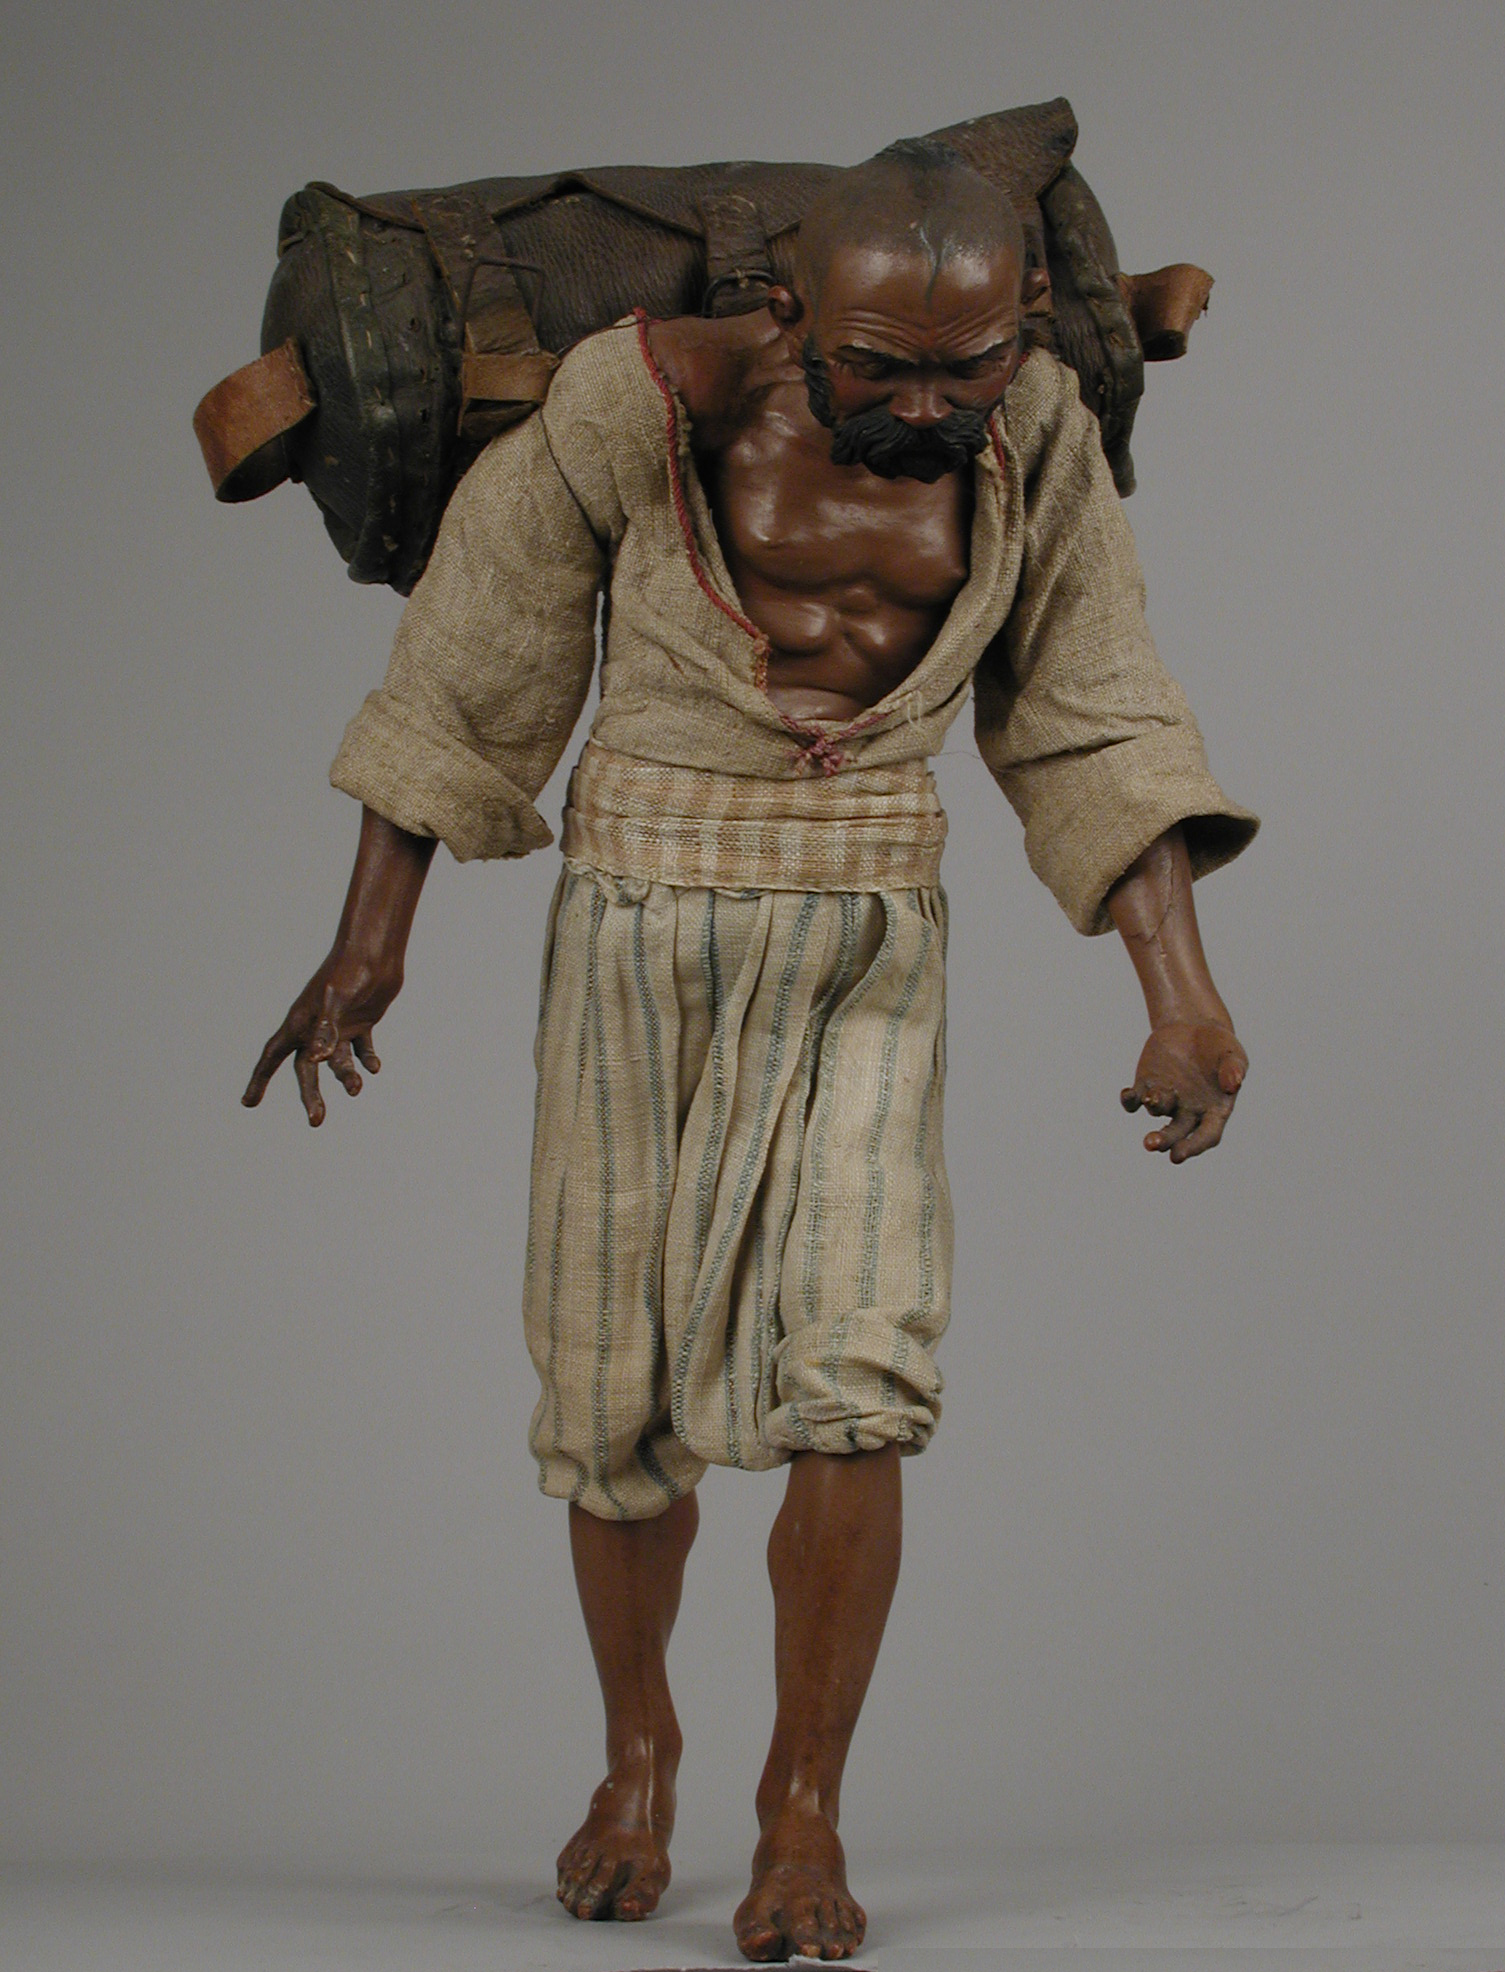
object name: crèche figure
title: Man with back pack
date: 1767-1833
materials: textile, leather, metal, terracotta, wood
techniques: polychrome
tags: men